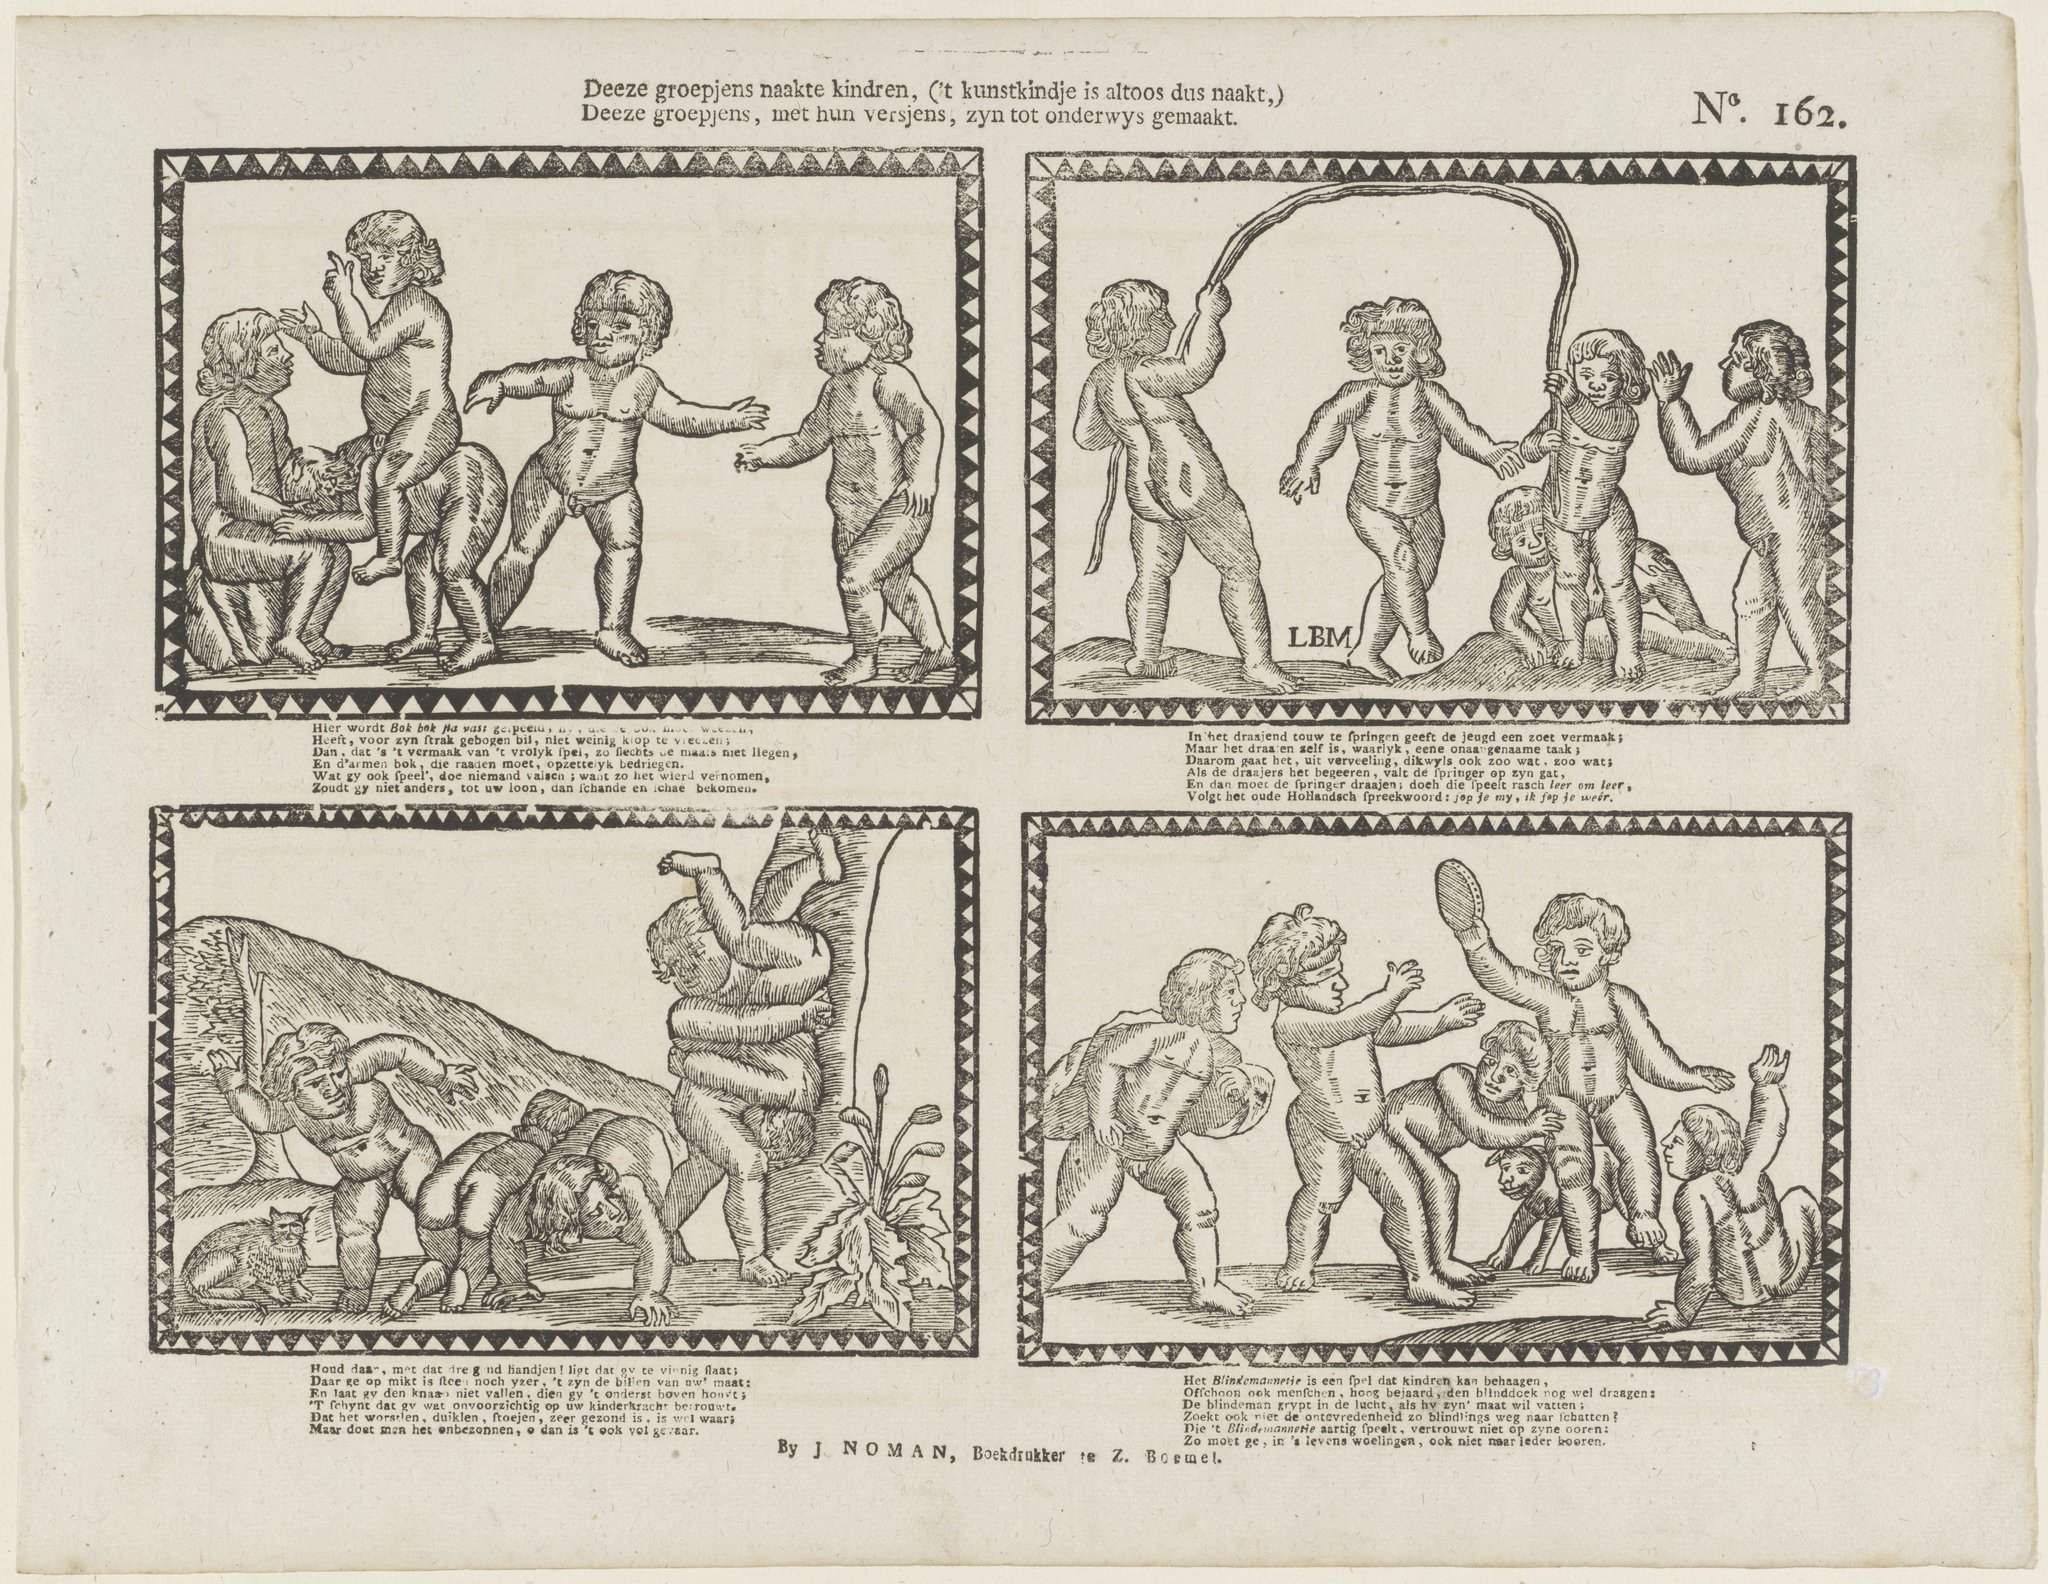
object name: popular print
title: Deeze groepjens naakte kindren, ('t kunstkindje is altoos dus naakt,) / Deeze groepjens, met hun versjens, zyn tot onderwys gemaakt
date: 1806-1830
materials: paper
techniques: letterpress printing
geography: netherlands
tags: children's games and plays, blind-man's buff, jumping-rope games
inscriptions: collector's mark: Lugt 2760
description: Blad met 4 voorstellingen van kinderspelen, zoals touwtjespringen en blindemannetje, verbeeld met naakte kinderen. Onder elke afbeelding een zesregelig vers. Genummerd rechtsboven: No. 162.